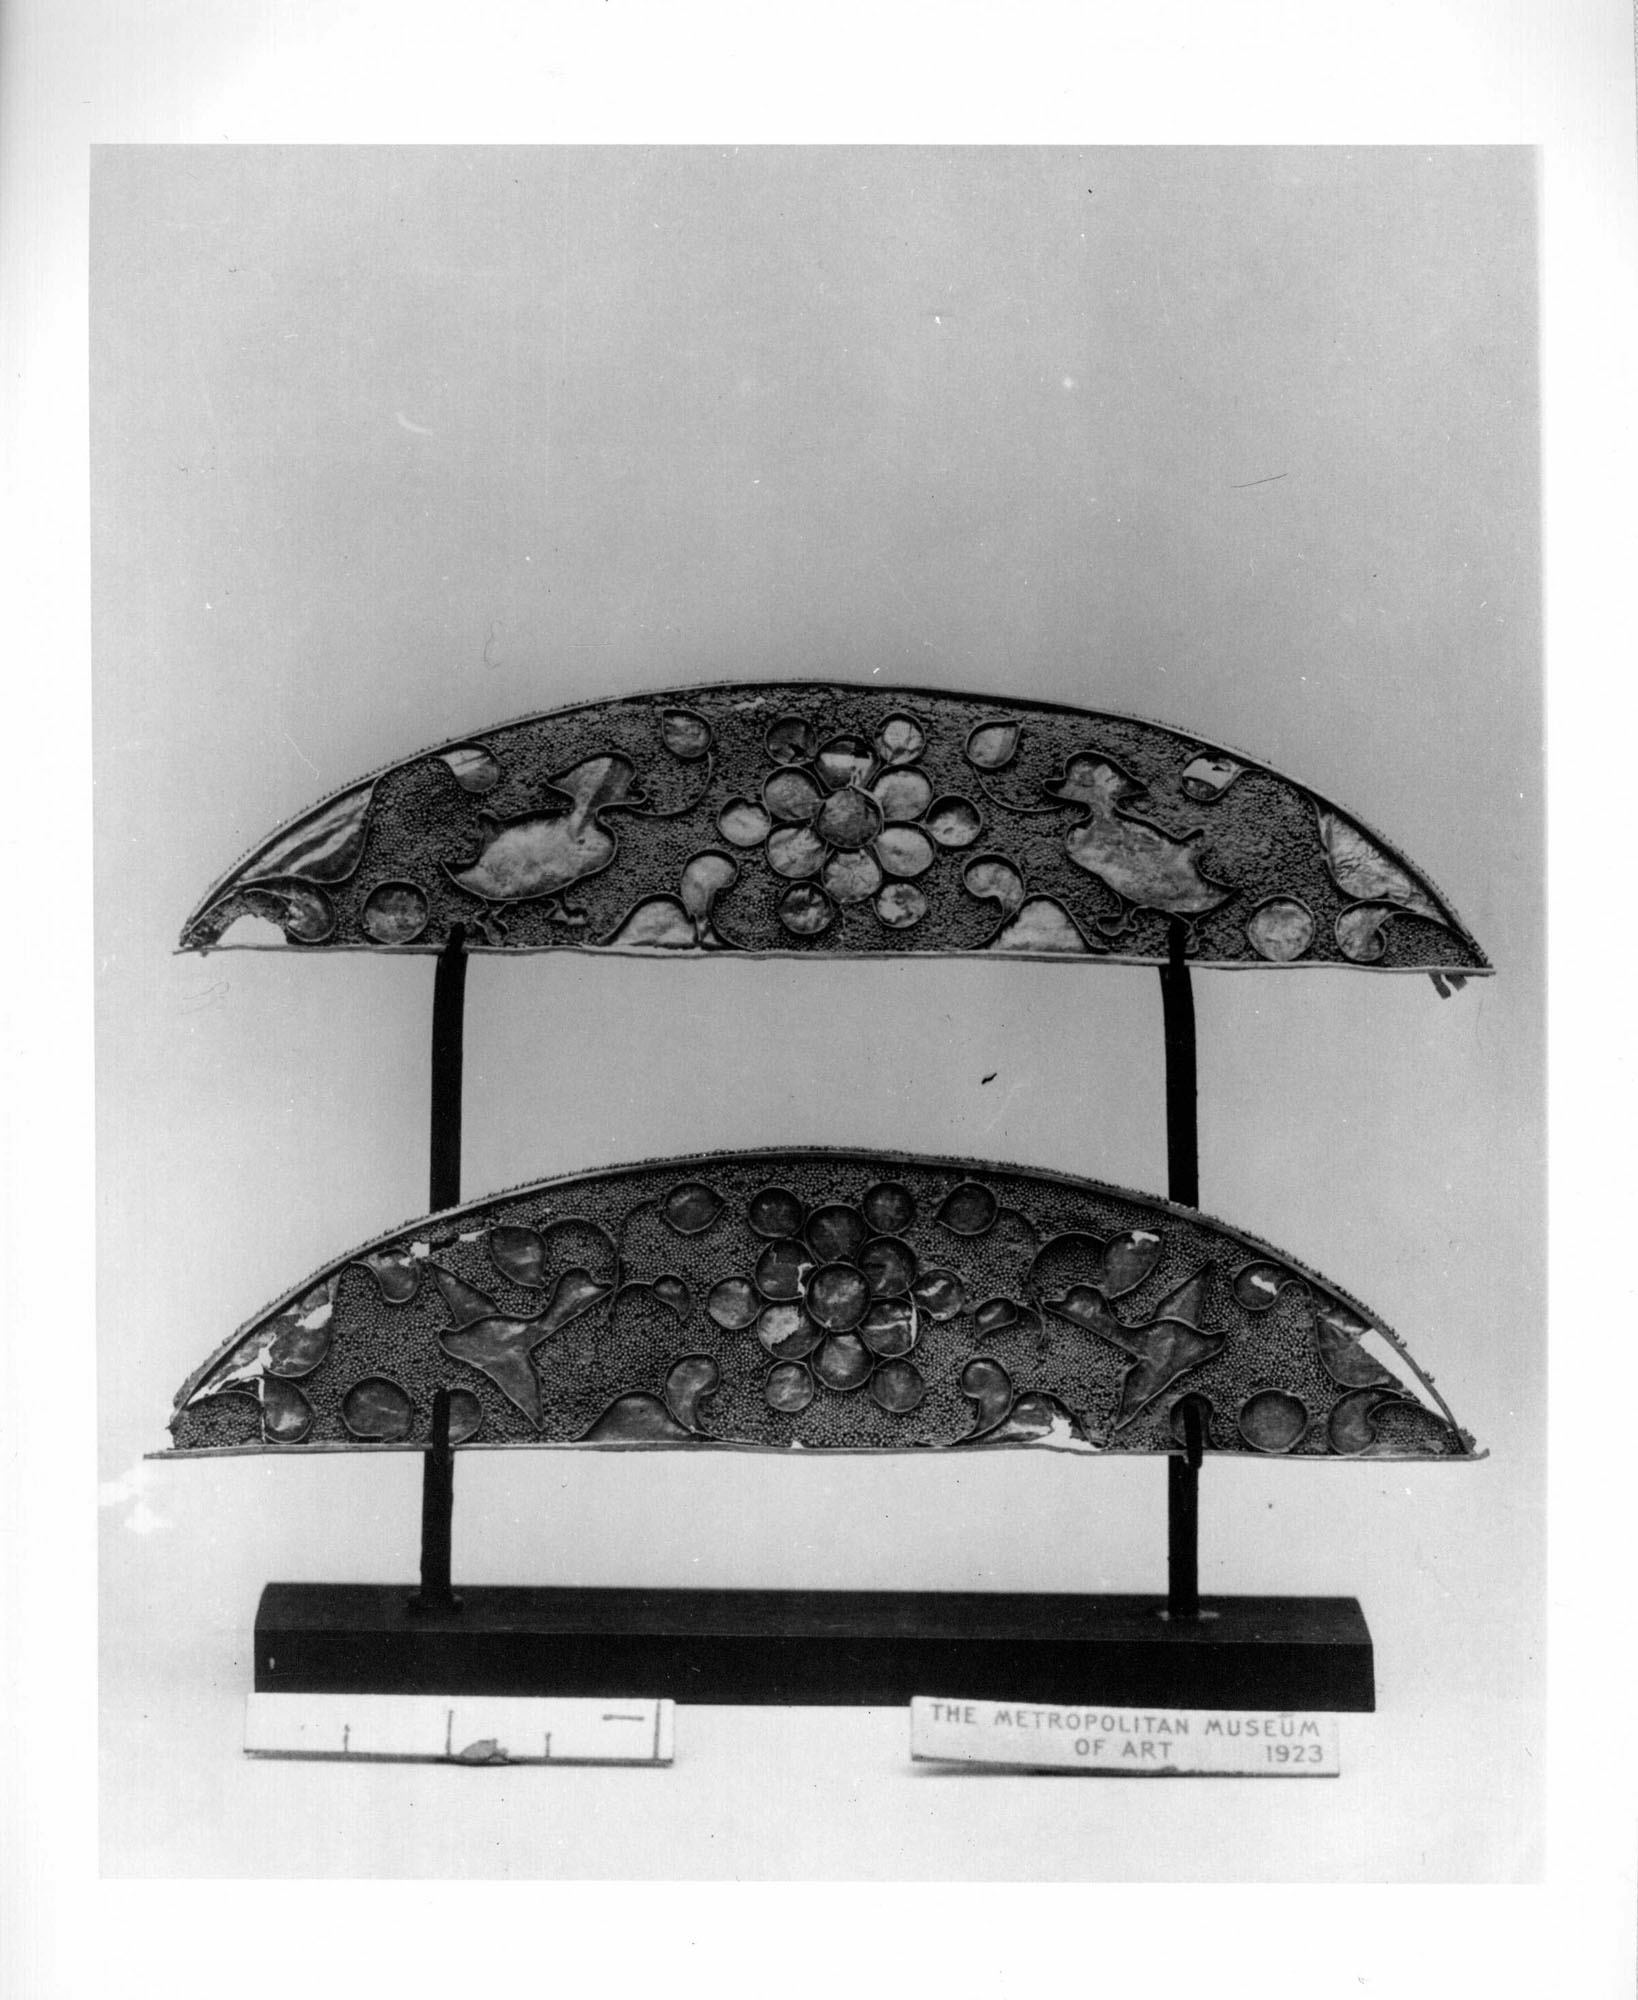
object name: comb top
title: Comb Tops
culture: chinese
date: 701-800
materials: gold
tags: ducks